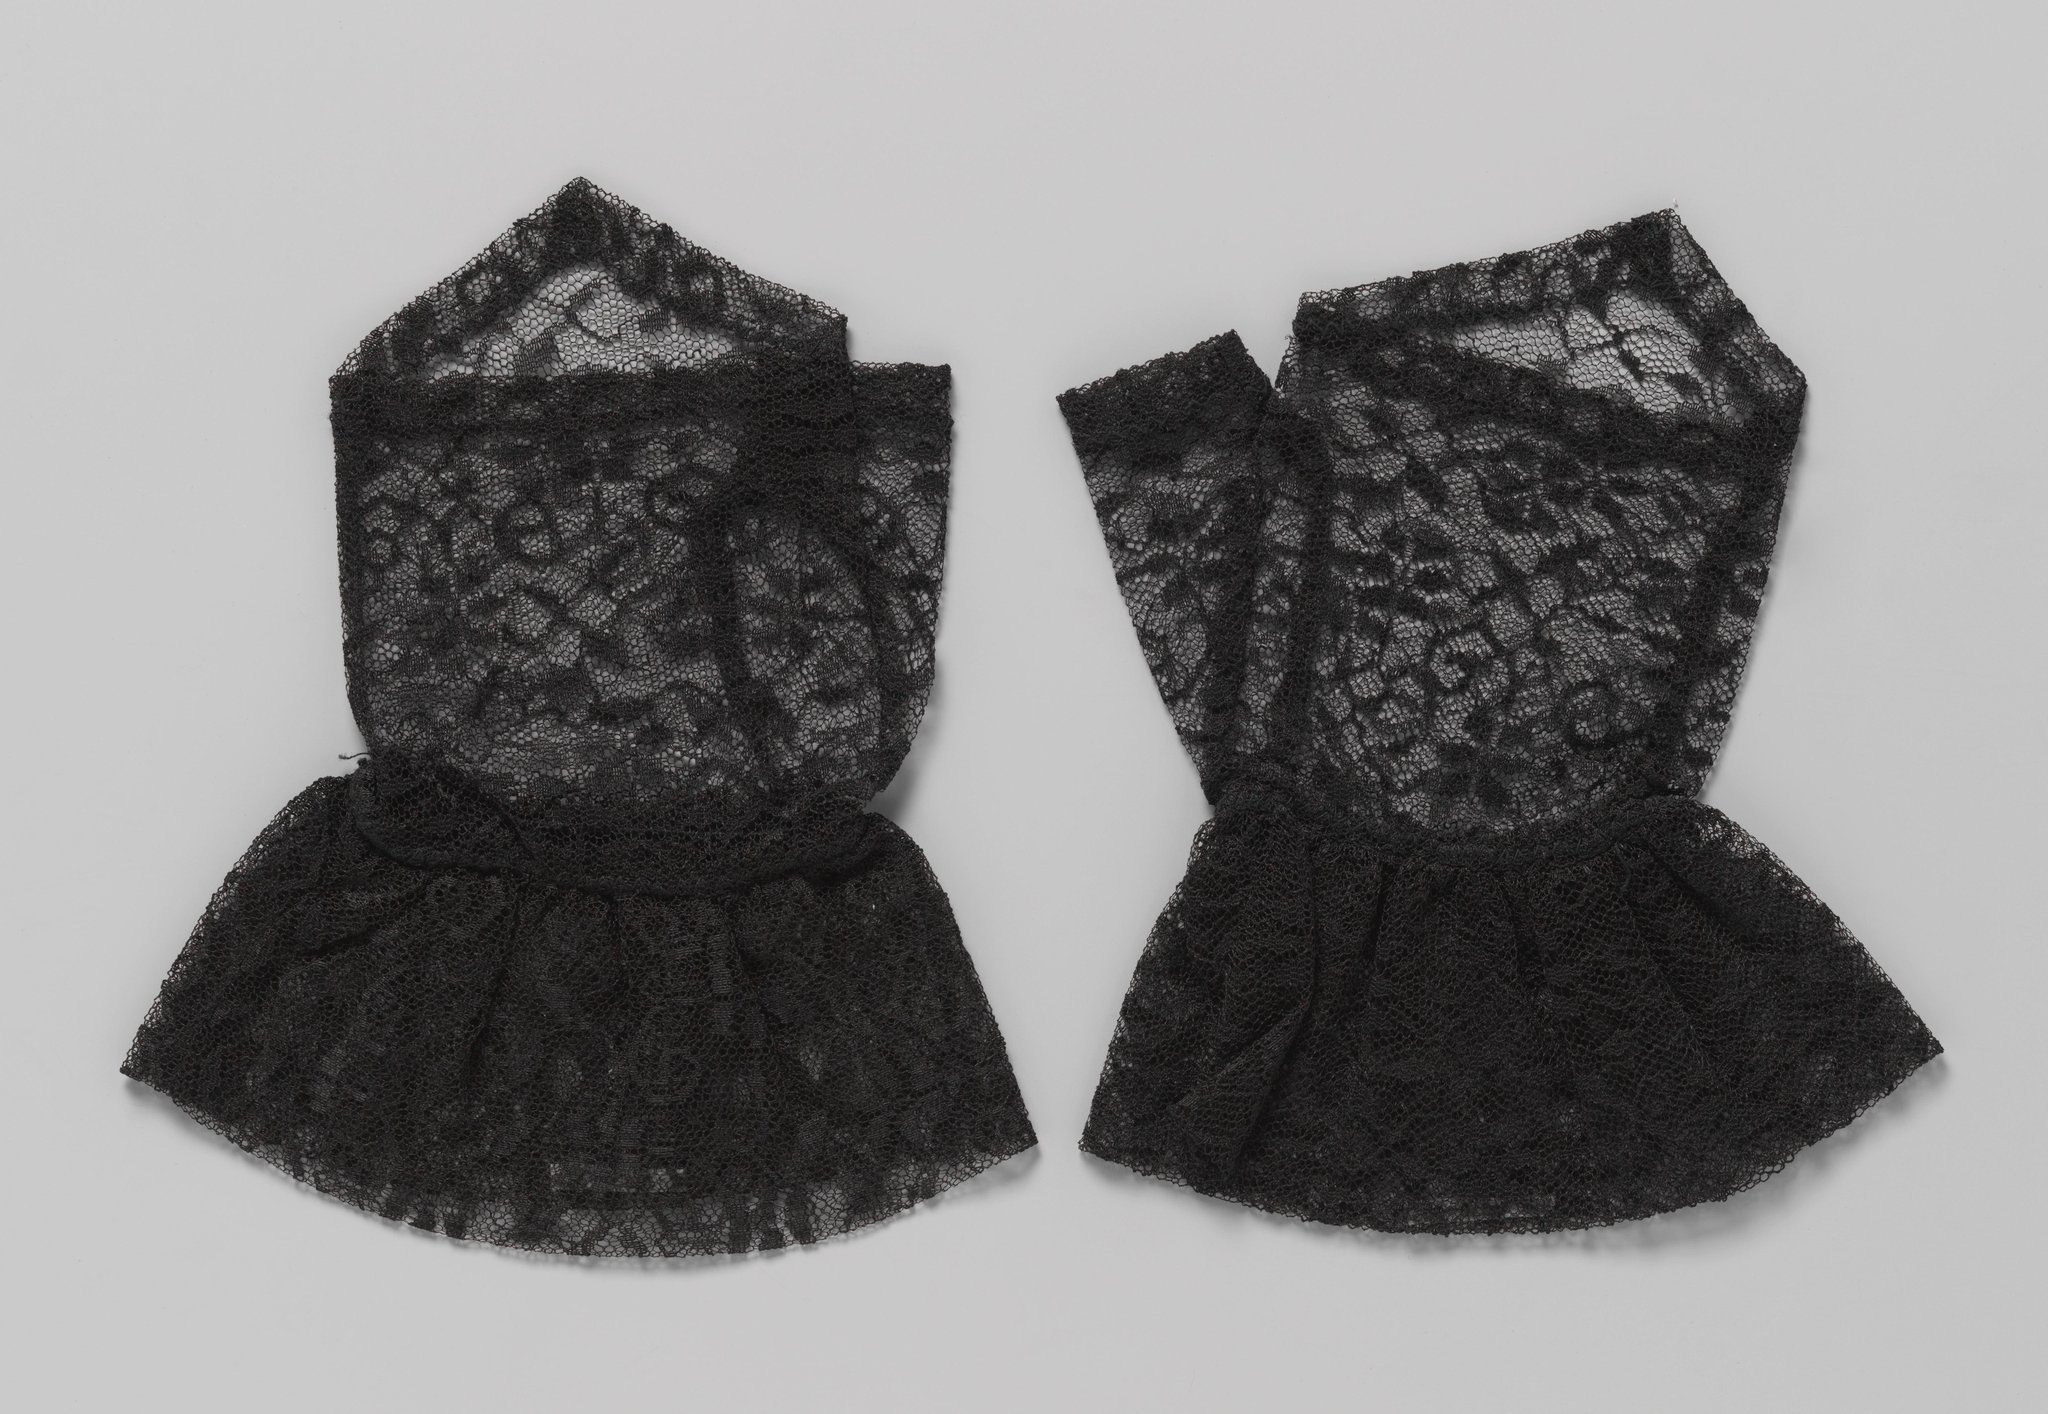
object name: mitt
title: Mitaine van zwarte machinale kant met een punt op de hand(rug) en rondom de pols een gerimpelde strook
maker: Anonymous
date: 1900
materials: cotton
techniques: lace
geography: western europe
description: Mitaine van zwarte machinale kant: machinale Chantilly-kant. De mitaine heeft een punt op de hand(rug) en rondom de pols een gerimpelde strook. Patroon met krullende ijle c-voluten en gestileerde bloemen met zes losse bloemblaadjes. Verbindingen tussen de motieven door takjes met enkele blaadjes.